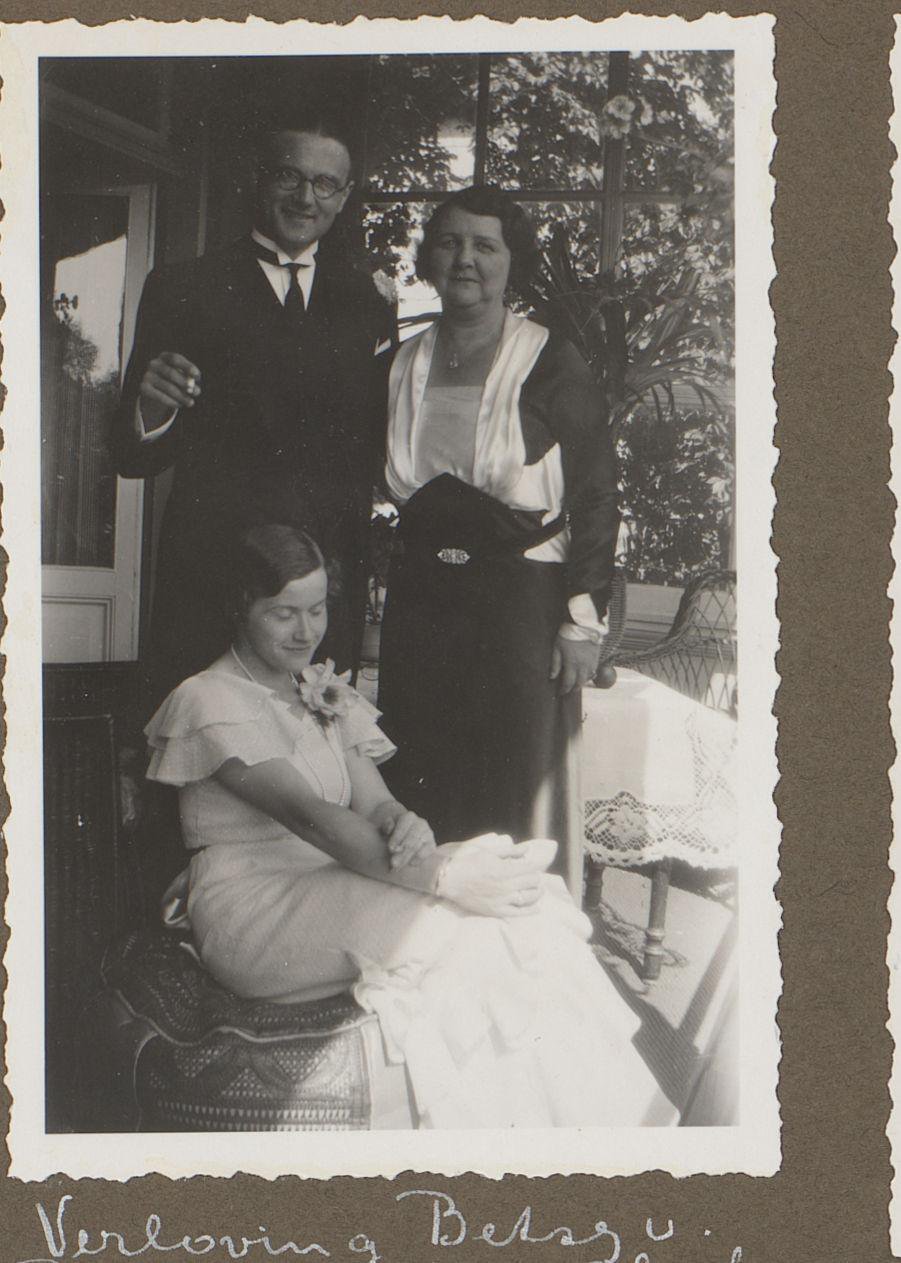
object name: photograph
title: Wim Heskes en Betsy van Bergen bij hun verloving, met Henriëtte van Bergen-Rijnders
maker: Anonymous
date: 1907-1933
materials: paper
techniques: gelatin silver print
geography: the hague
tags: batavia, couple of lovers, betrothal, the hague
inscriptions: inscription: ‘Verloving Betsy v./ Bergen & Wim Heskes/ Juli 1933’